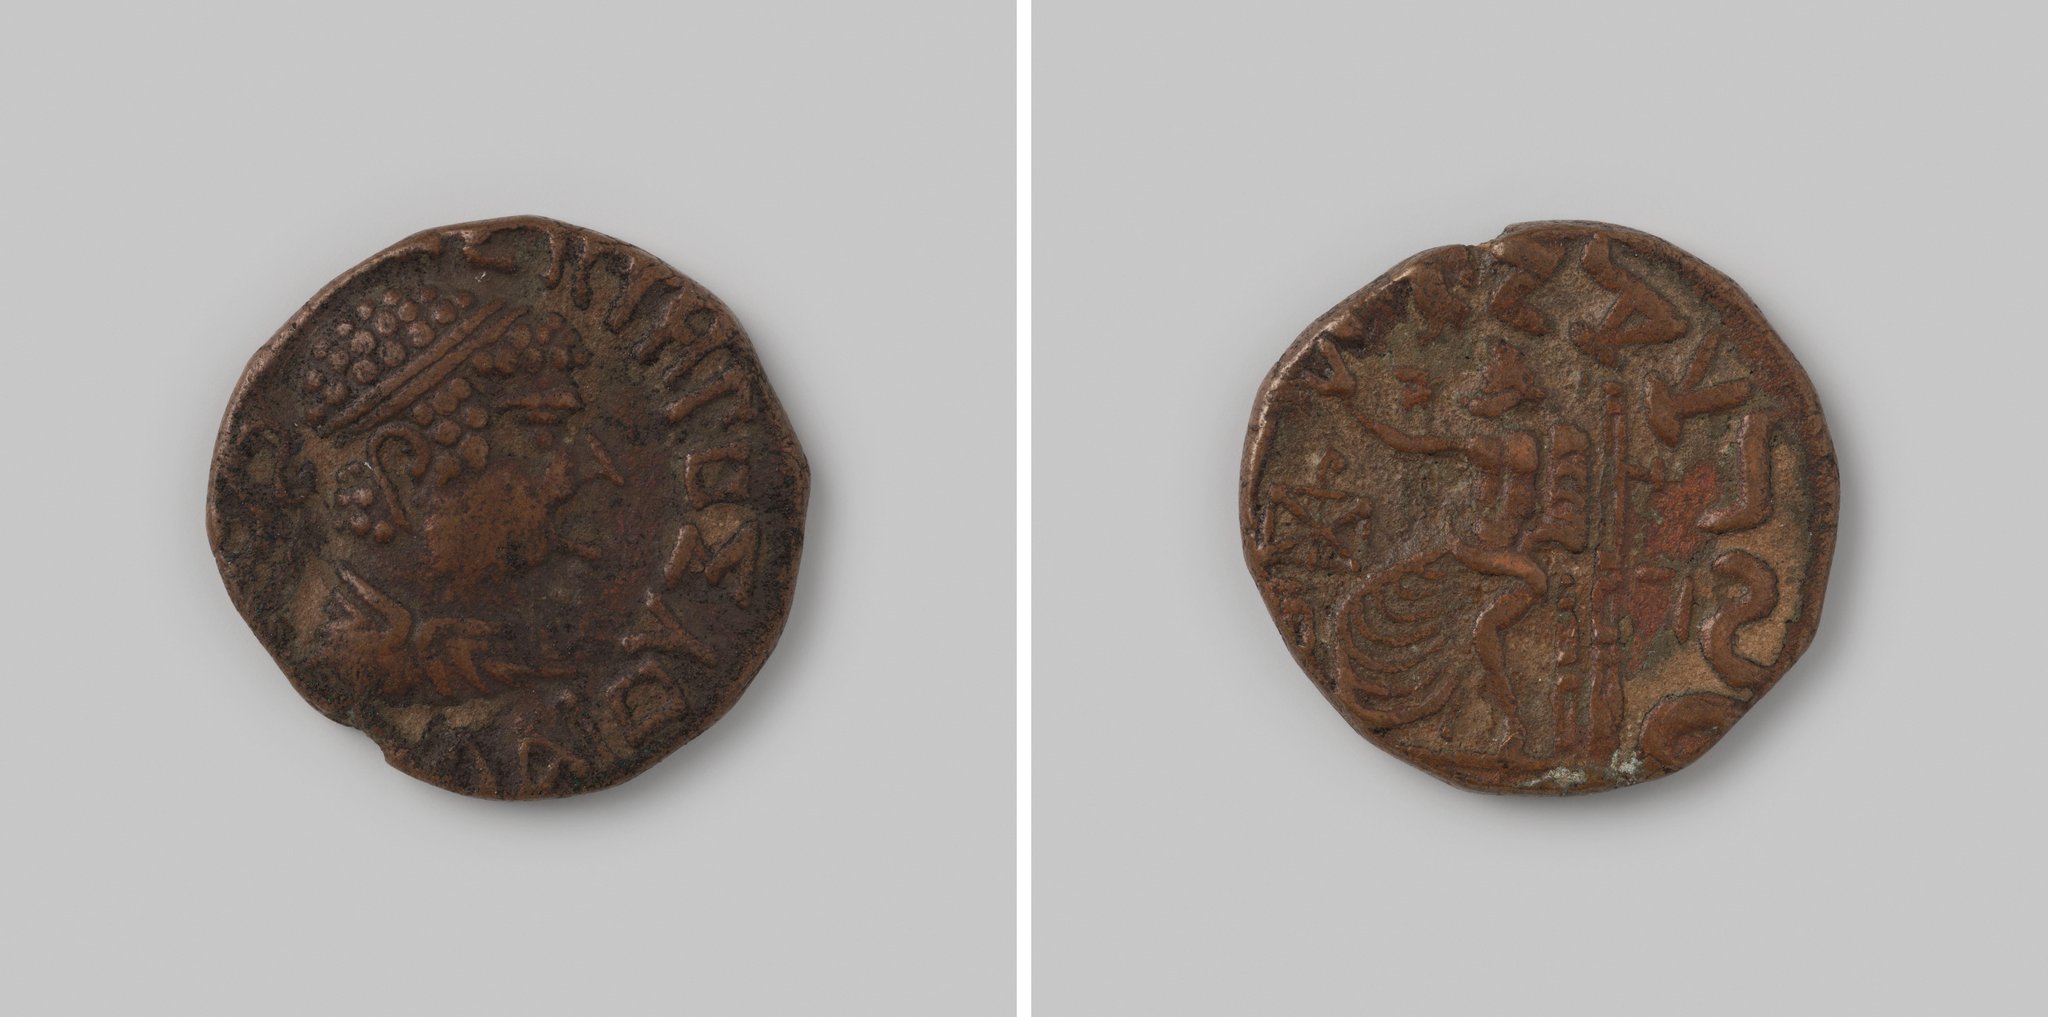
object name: coin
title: Tetradrachme uit Bactrië van koning Hermaios (Hermaeus) Soter, -40 / -1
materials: bronze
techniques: striking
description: Bronzen munt. Voorzijde: borstbeeld van de koning met diadeem naar rechts. Grieks omschrift. Keerzijde: Zeus in zetel. Omschrift in Pali.